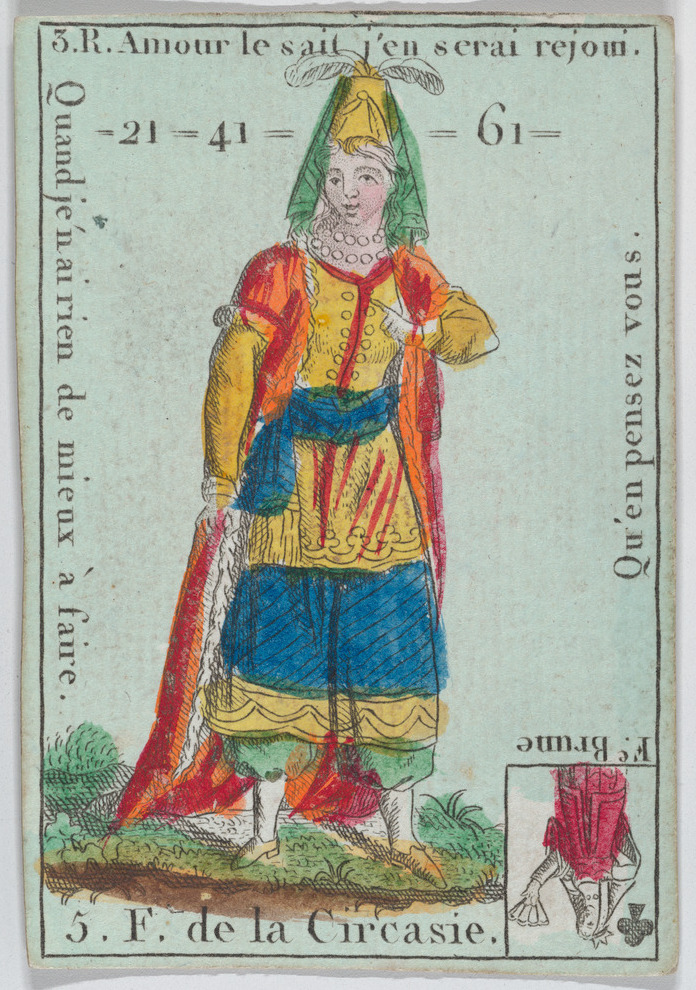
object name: print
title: F. de la Circasie from playing cards "Jeu d'Or"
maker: anonymous, french, 18th century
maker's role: artist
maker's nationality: french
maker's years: 1700-1800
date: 1700-1799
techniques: etching, hand coloring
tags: women,playing cards